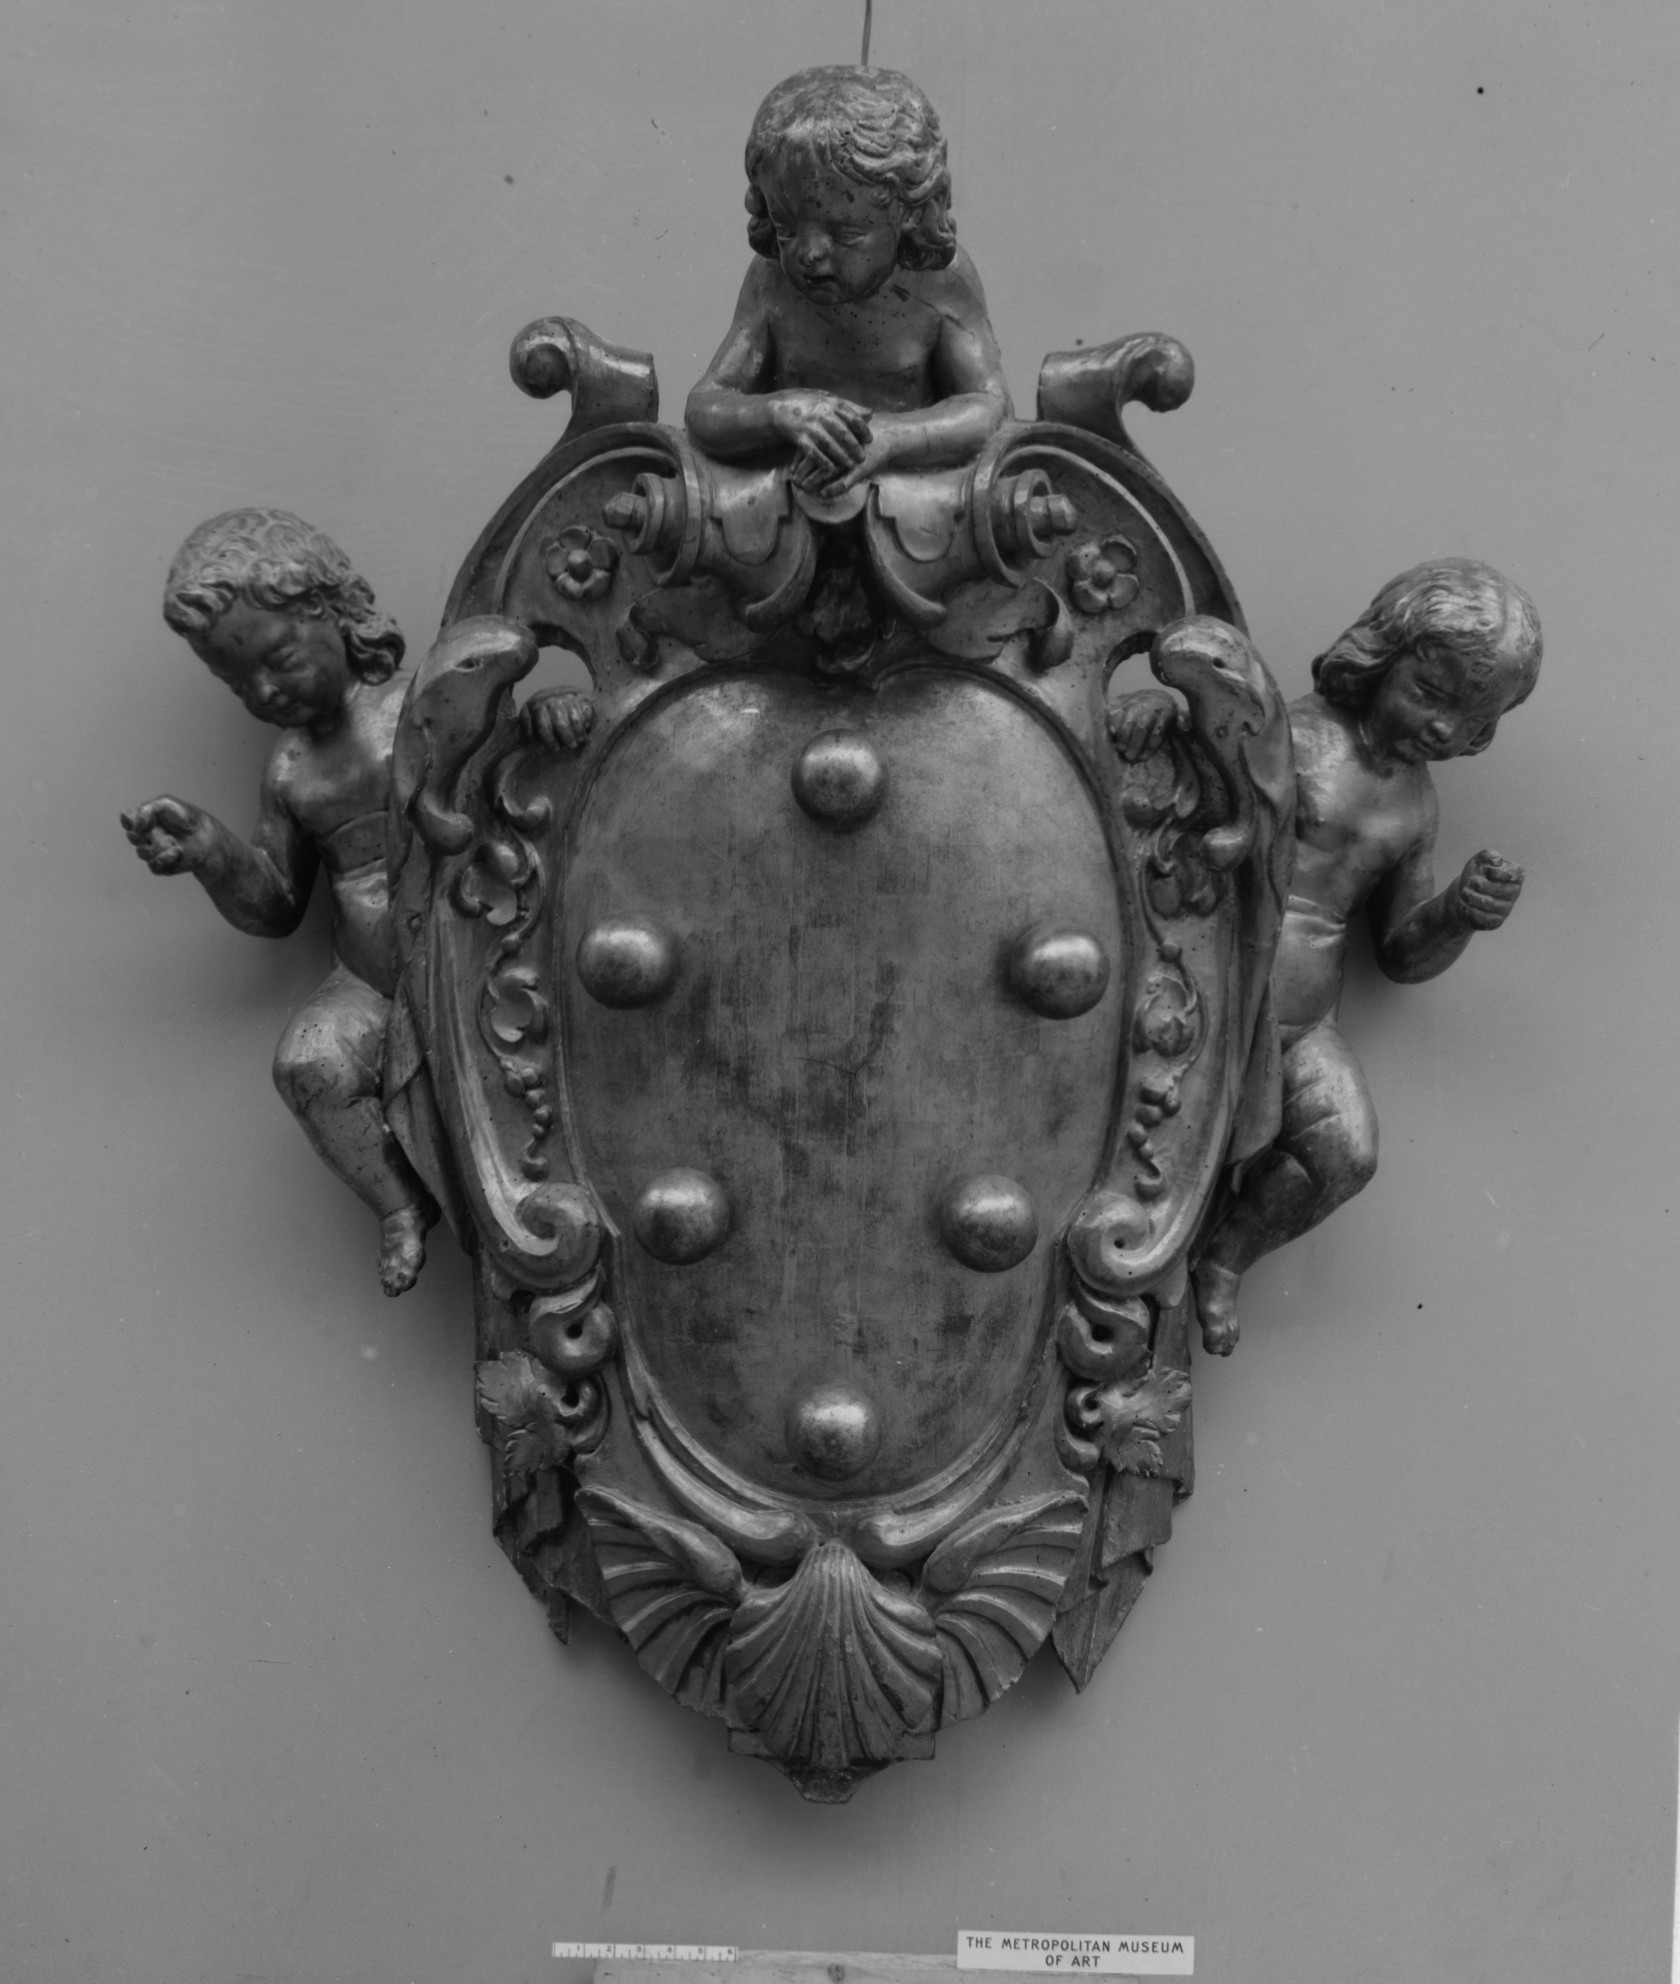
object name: armorial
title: Arms of Counts de Medici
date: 1667-1733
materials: wood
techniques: carving, gilding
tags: putti,coat of arms